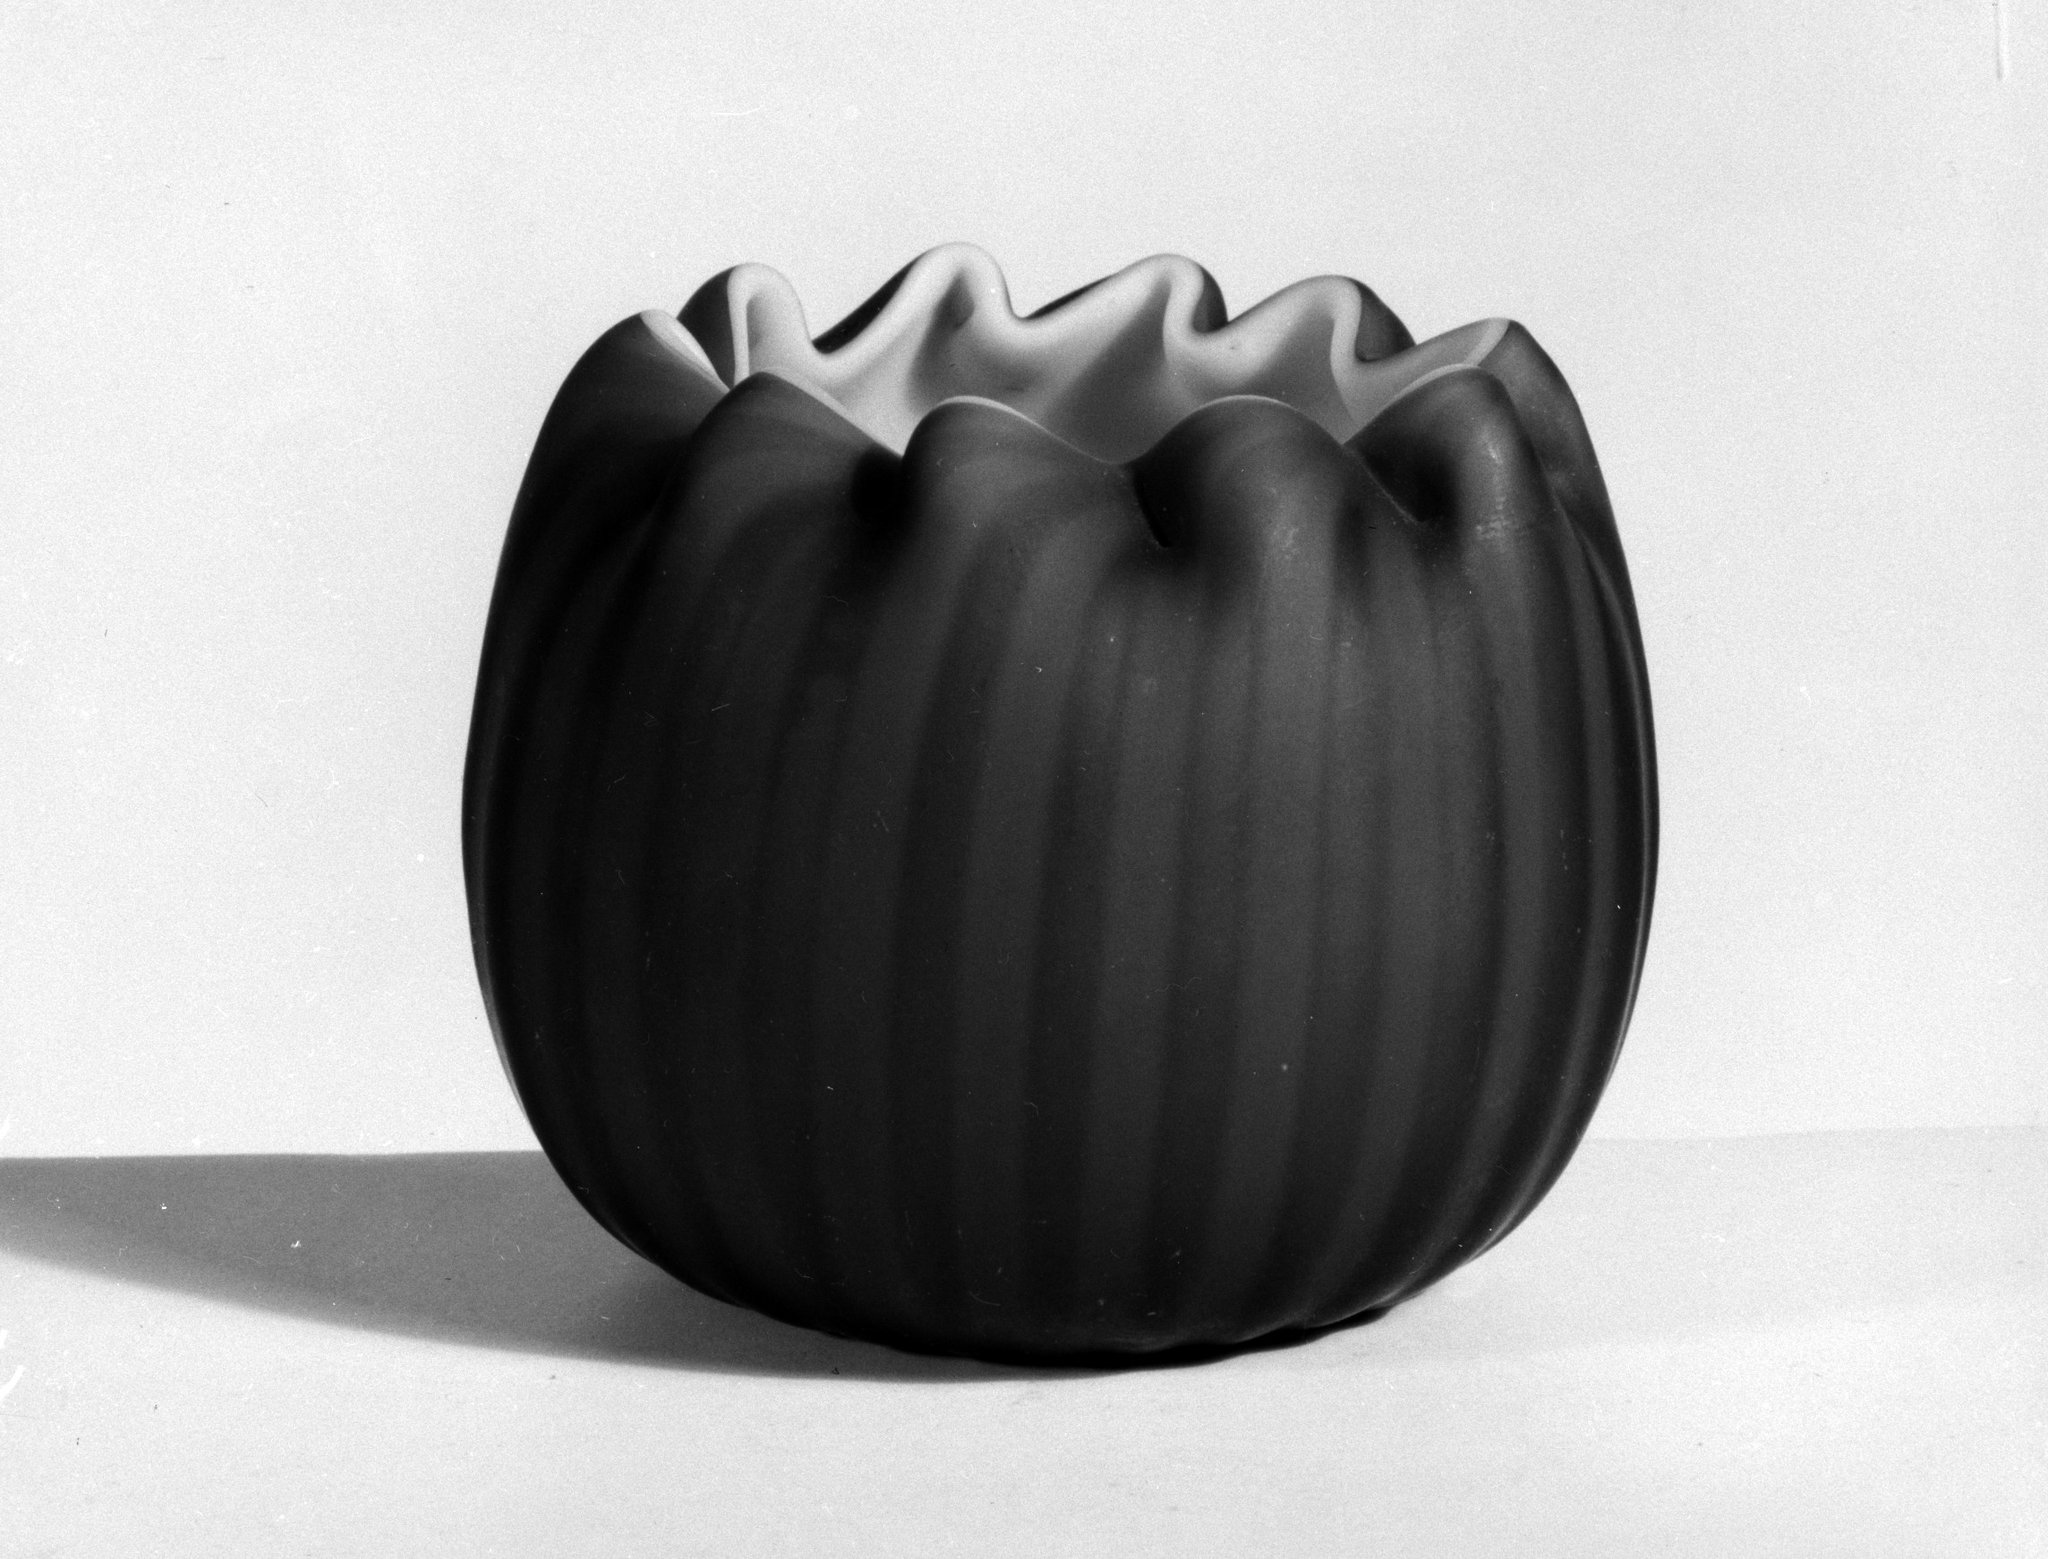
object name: bowl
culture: british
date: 1885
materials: glass, textile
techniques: glassblowing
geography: england